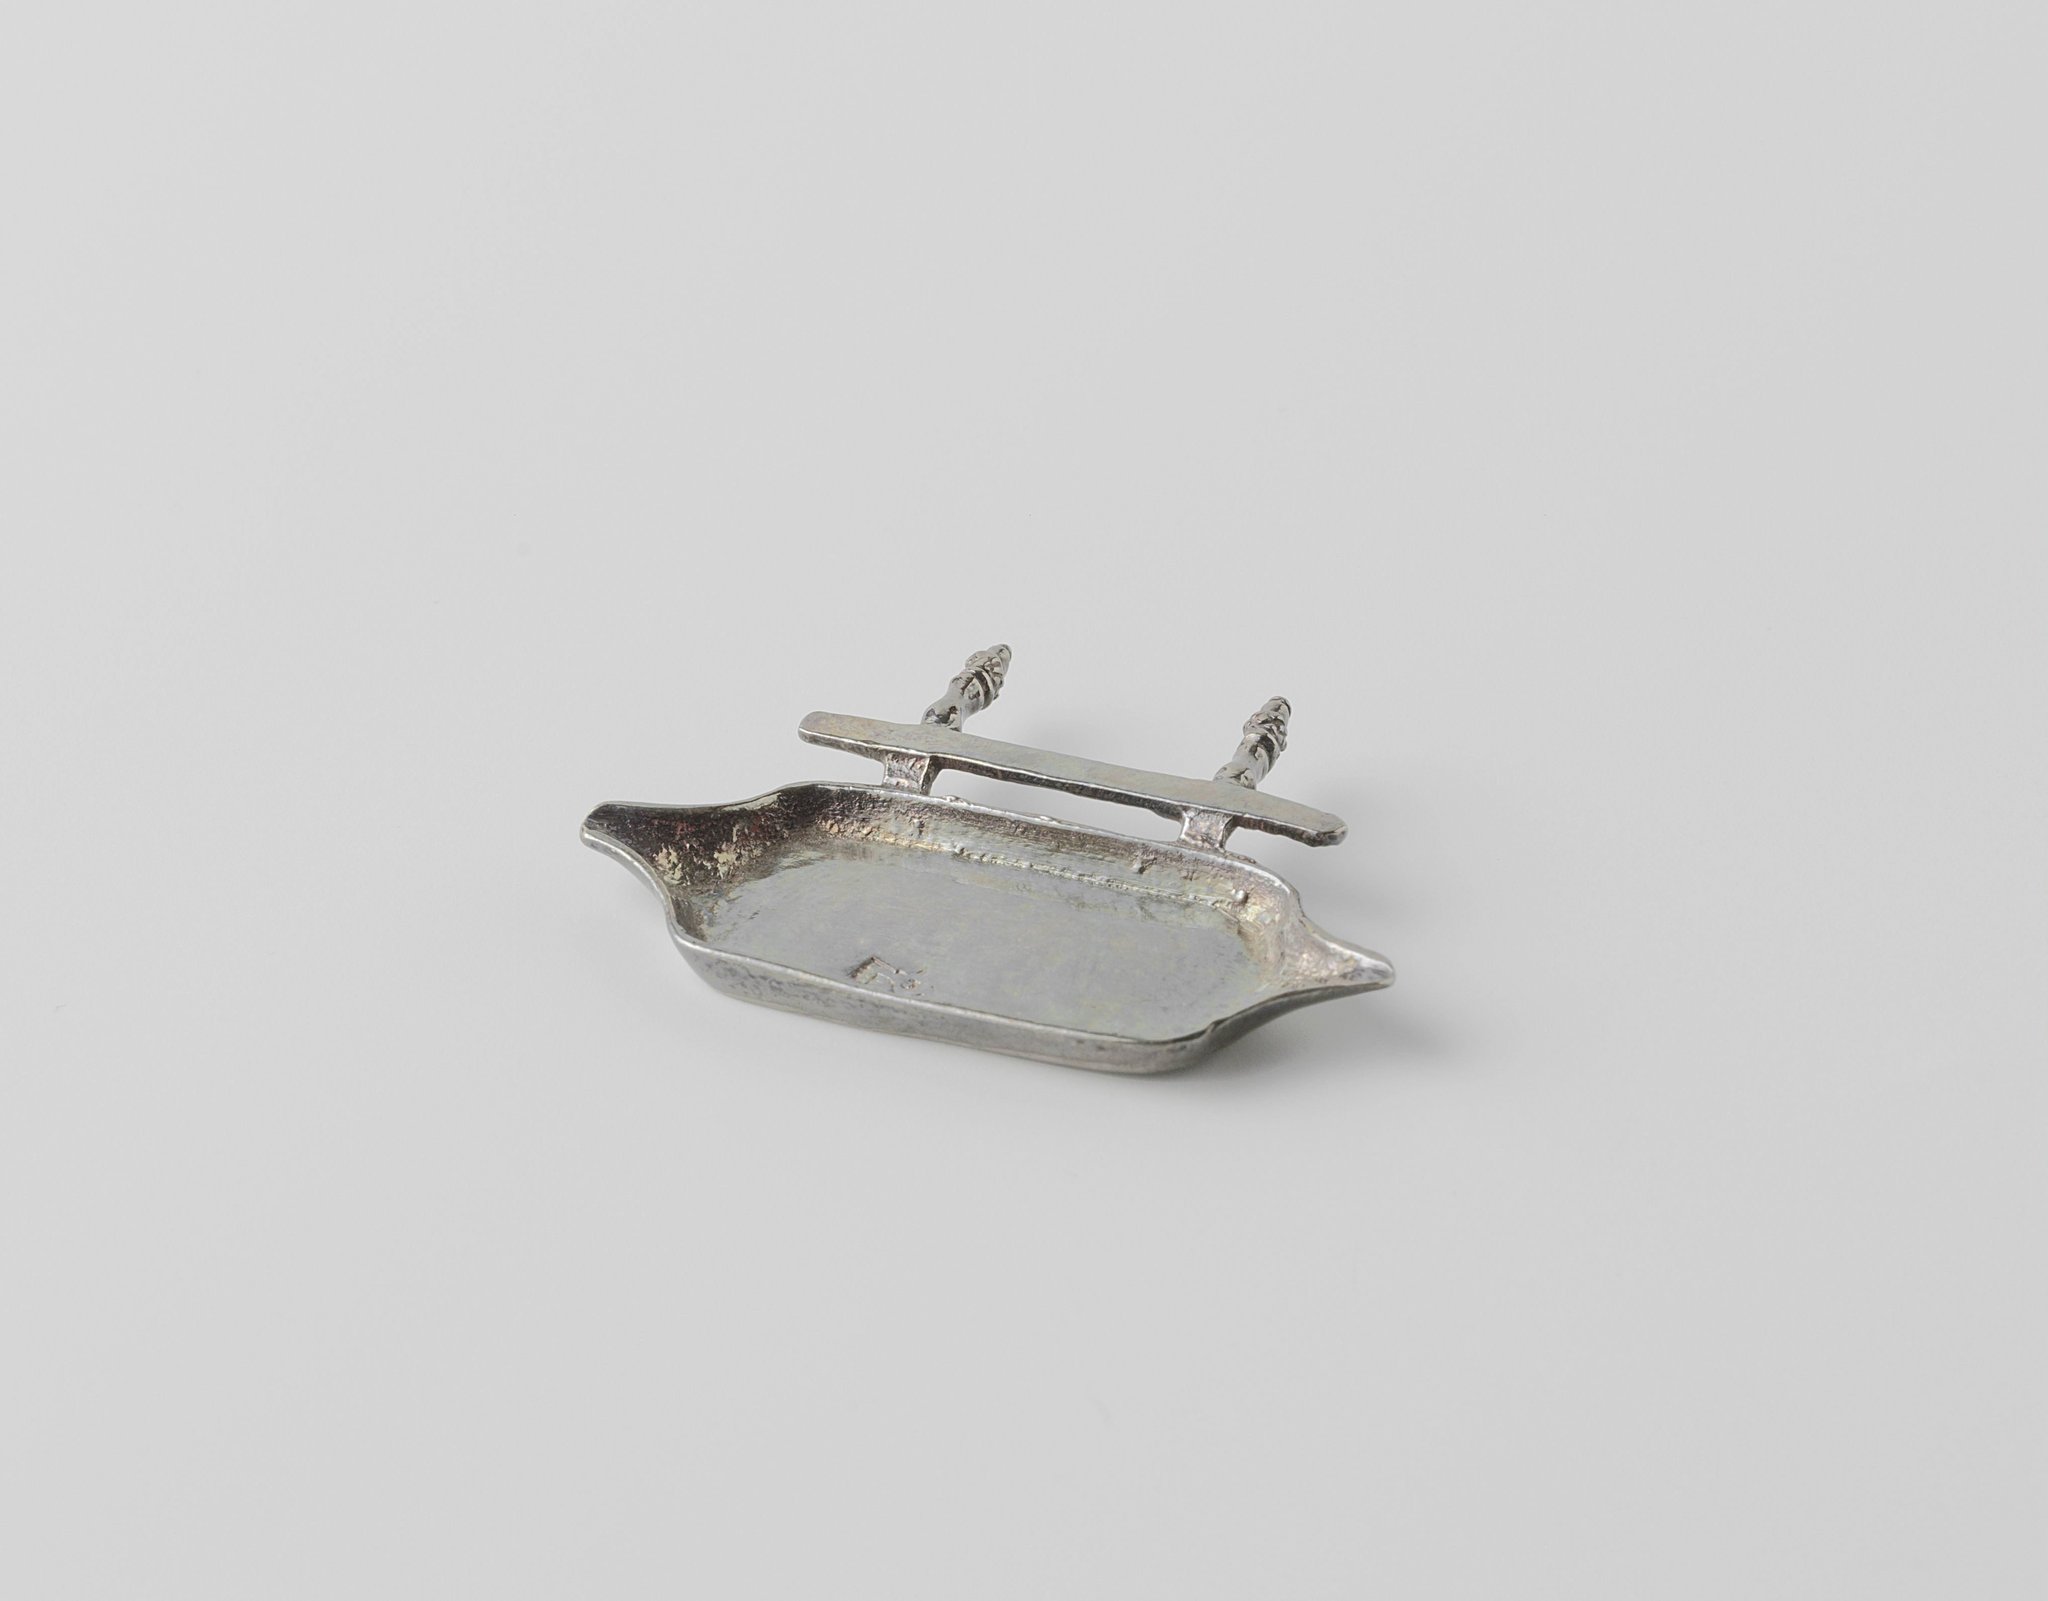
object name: miniature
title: Pan met twee handvatten en twee tuiten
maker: Anonymous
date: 1400-1950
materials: silver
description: Pan van zilver, rechthoekig, met twee handvatten en twee tuiten.